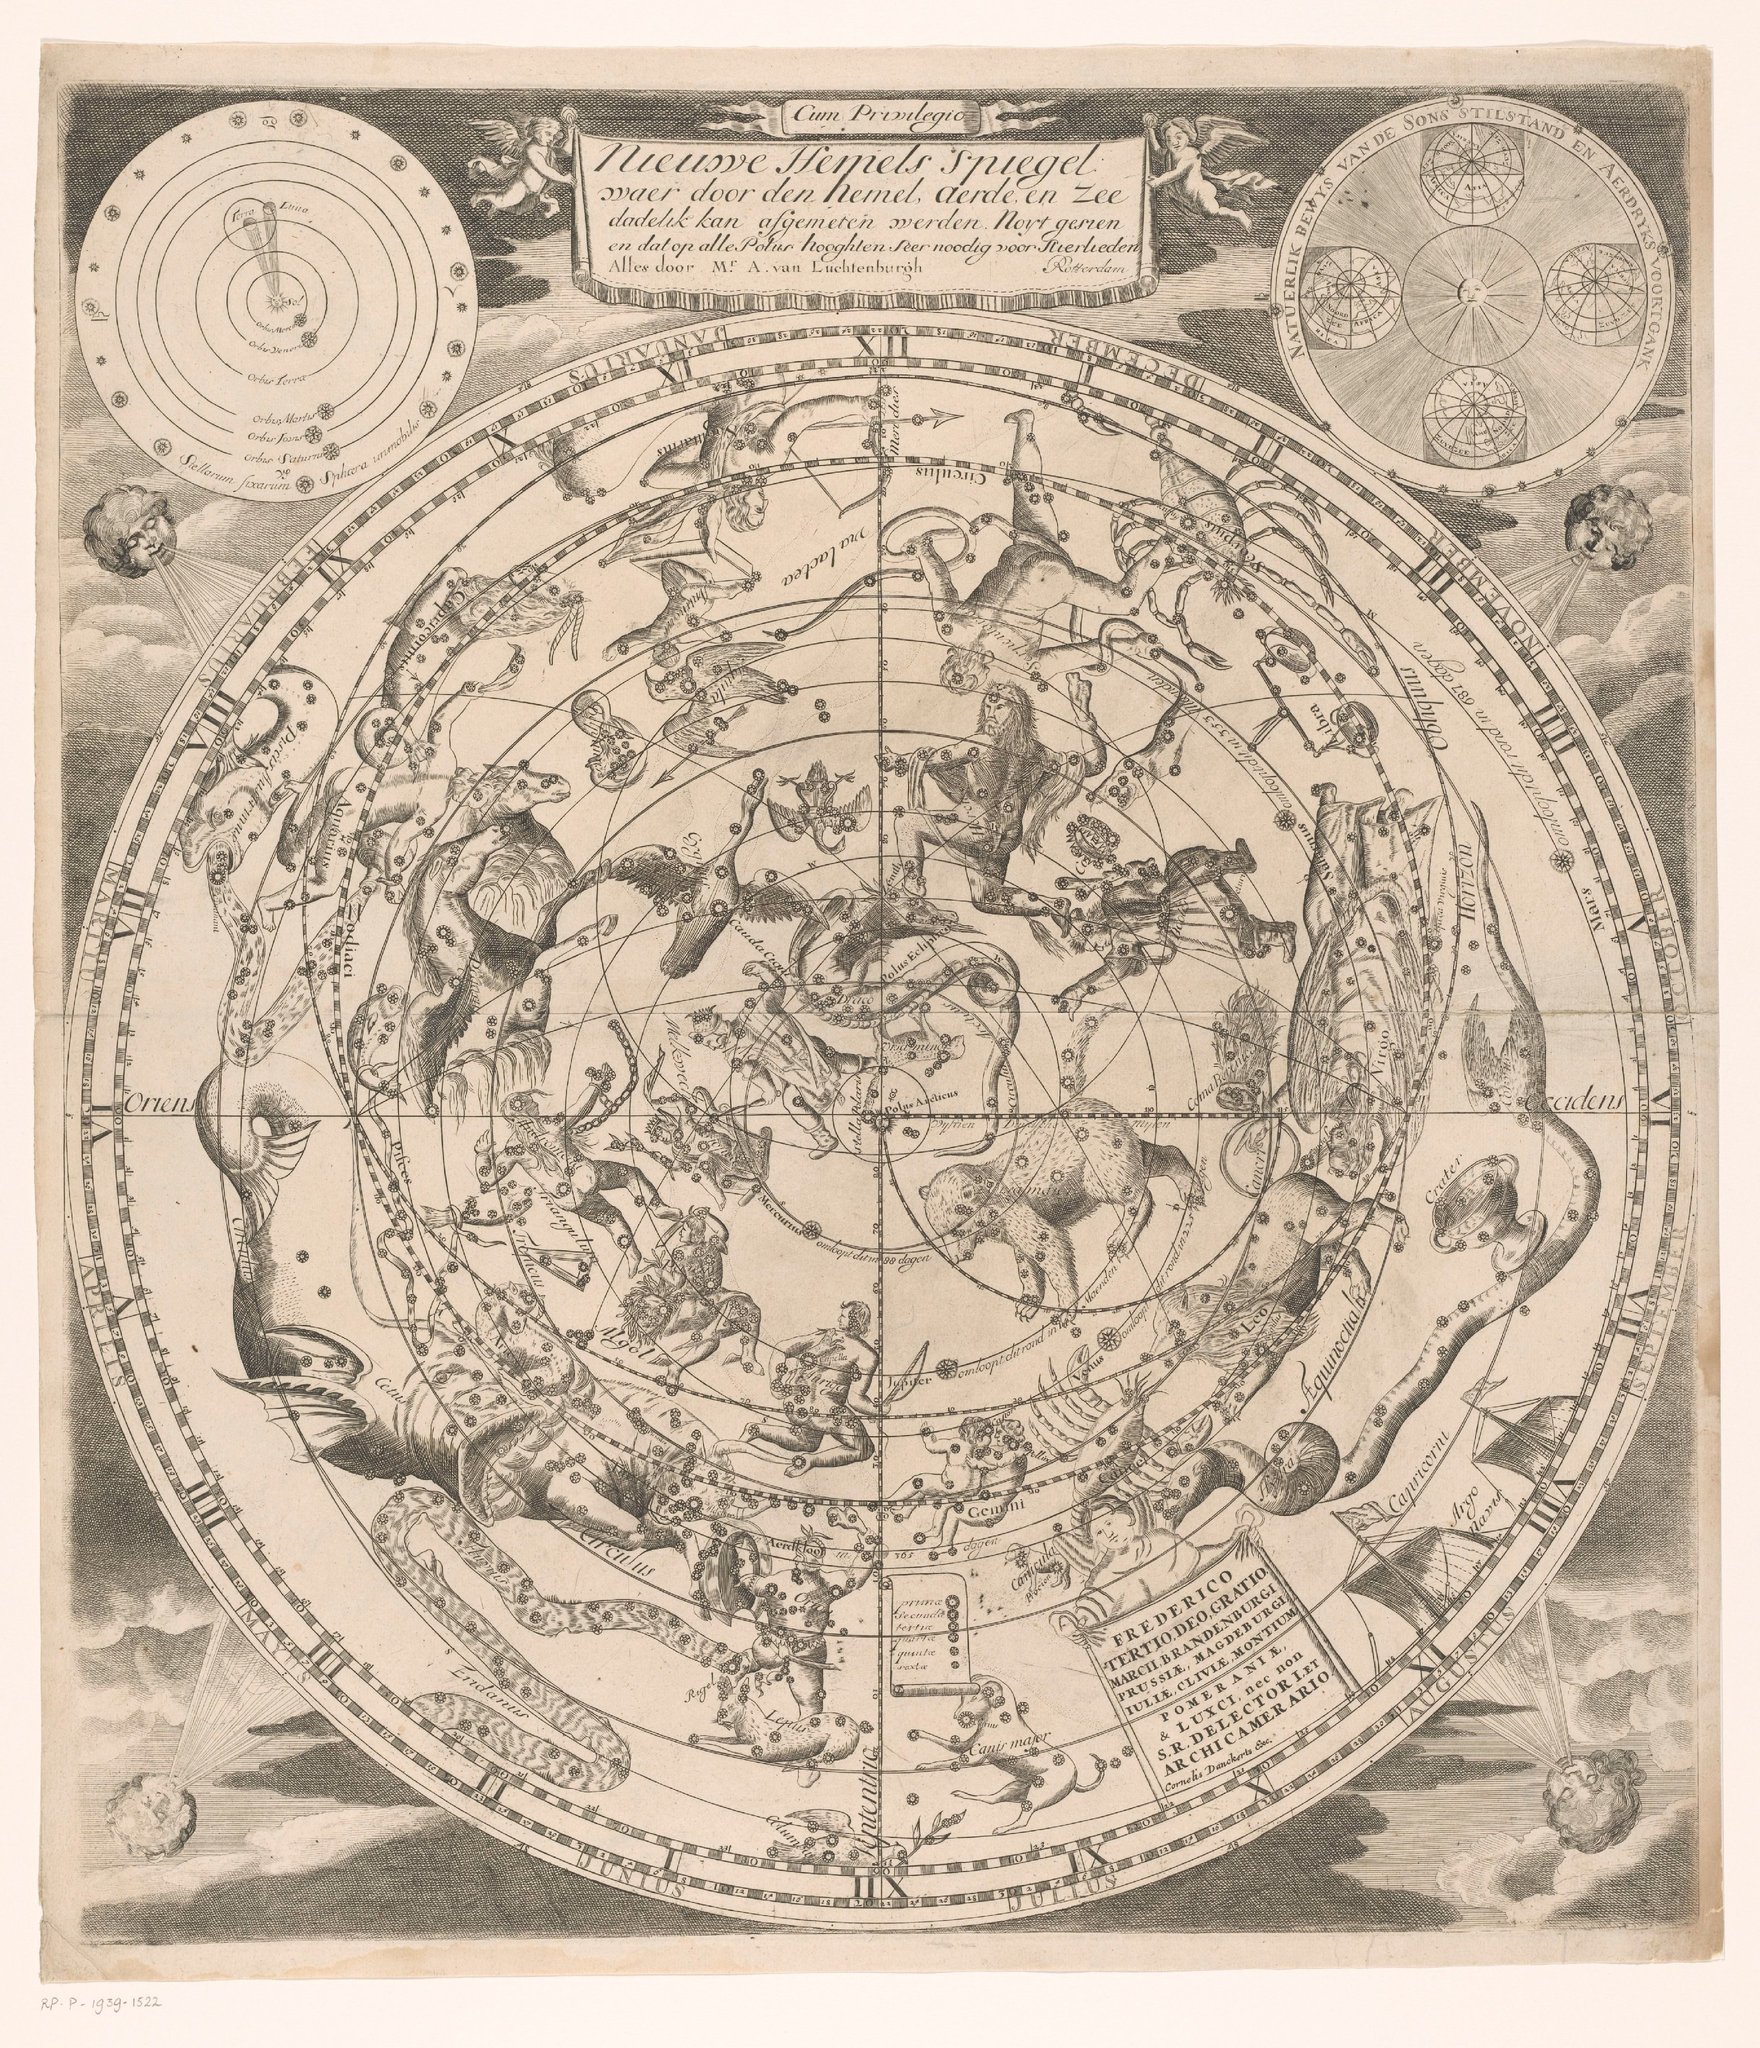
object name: print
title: Nieuwe hemels spiegel: waer door den hemel, aerde, en zee dadelik (...)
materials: paper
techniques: engraving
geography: rotterdam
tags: zodiac; the twelve zodiacal signs together, star-chart, star map, planets; planetary system, solar system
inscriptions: collector's mark: Lugt 2166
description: Hemelkaart met de noordelijke sterrenbeelden, gecentreerd rond de poolster. Boven, in het midden, de titelcartouche, gedragen door putti. Linksboven een weergave van het stelsel van Nicolaas Copernicus. Rechtsboven een weergave van de draaiing van de aarde om de zon.